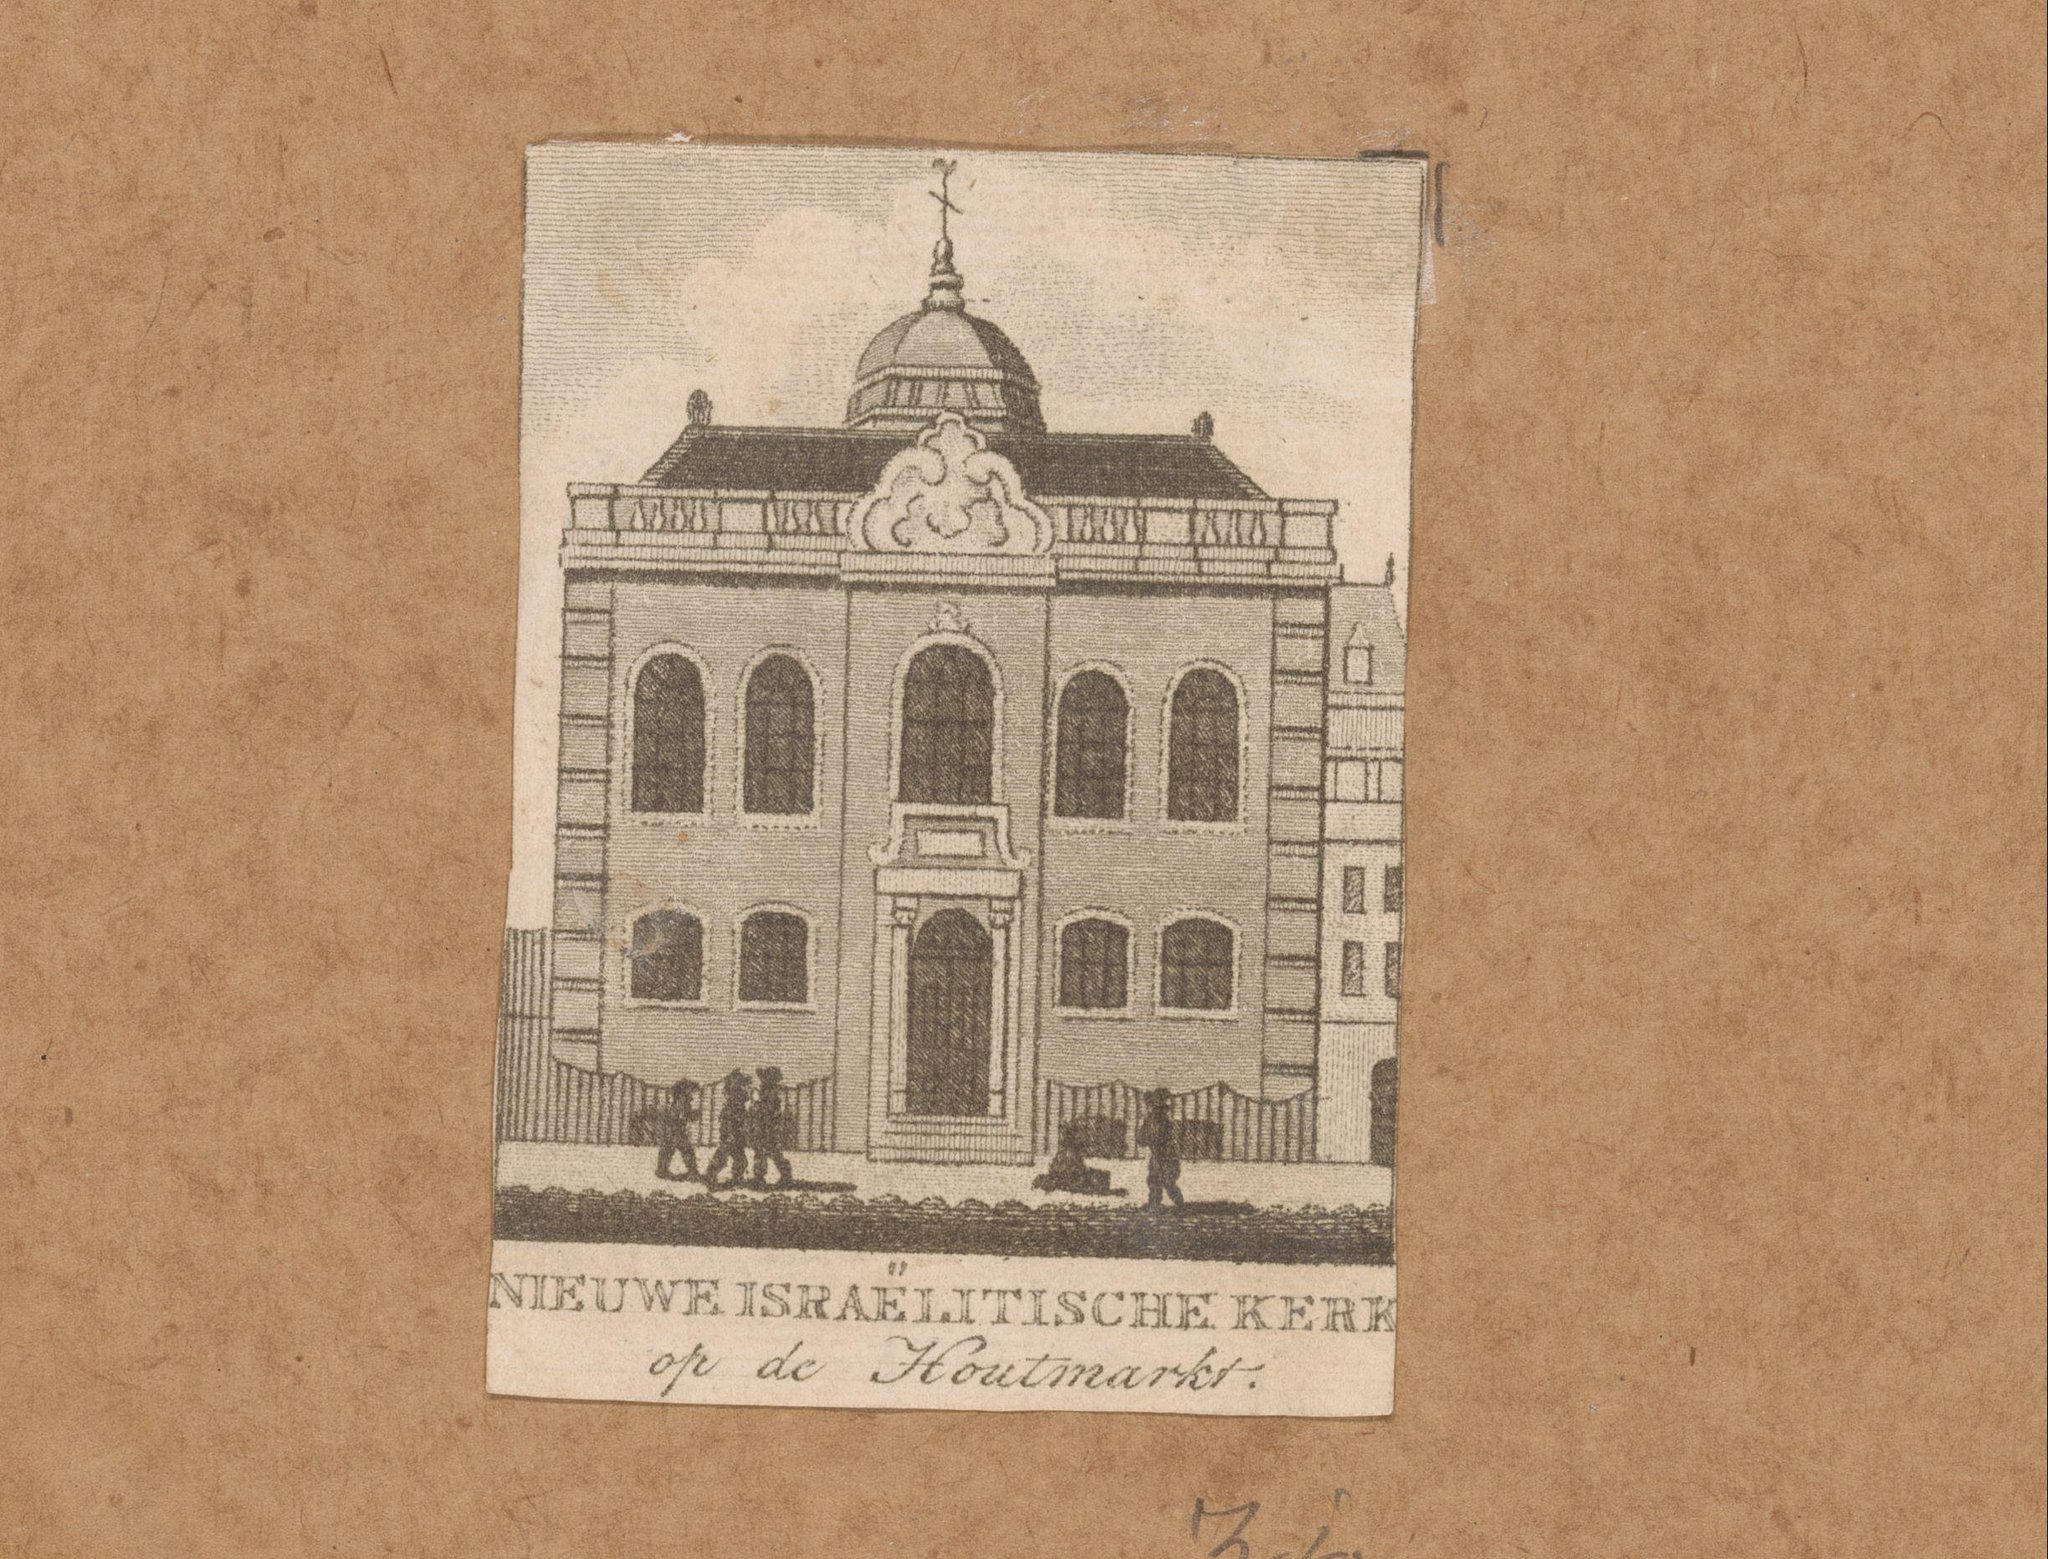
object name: print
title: Nieuwe Israëlitische kerk op de Houtmarkt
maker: Anonymous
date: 1800-1840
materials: paper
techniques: etching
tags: the synagogue (as building and place of worship ~ jewish religion)